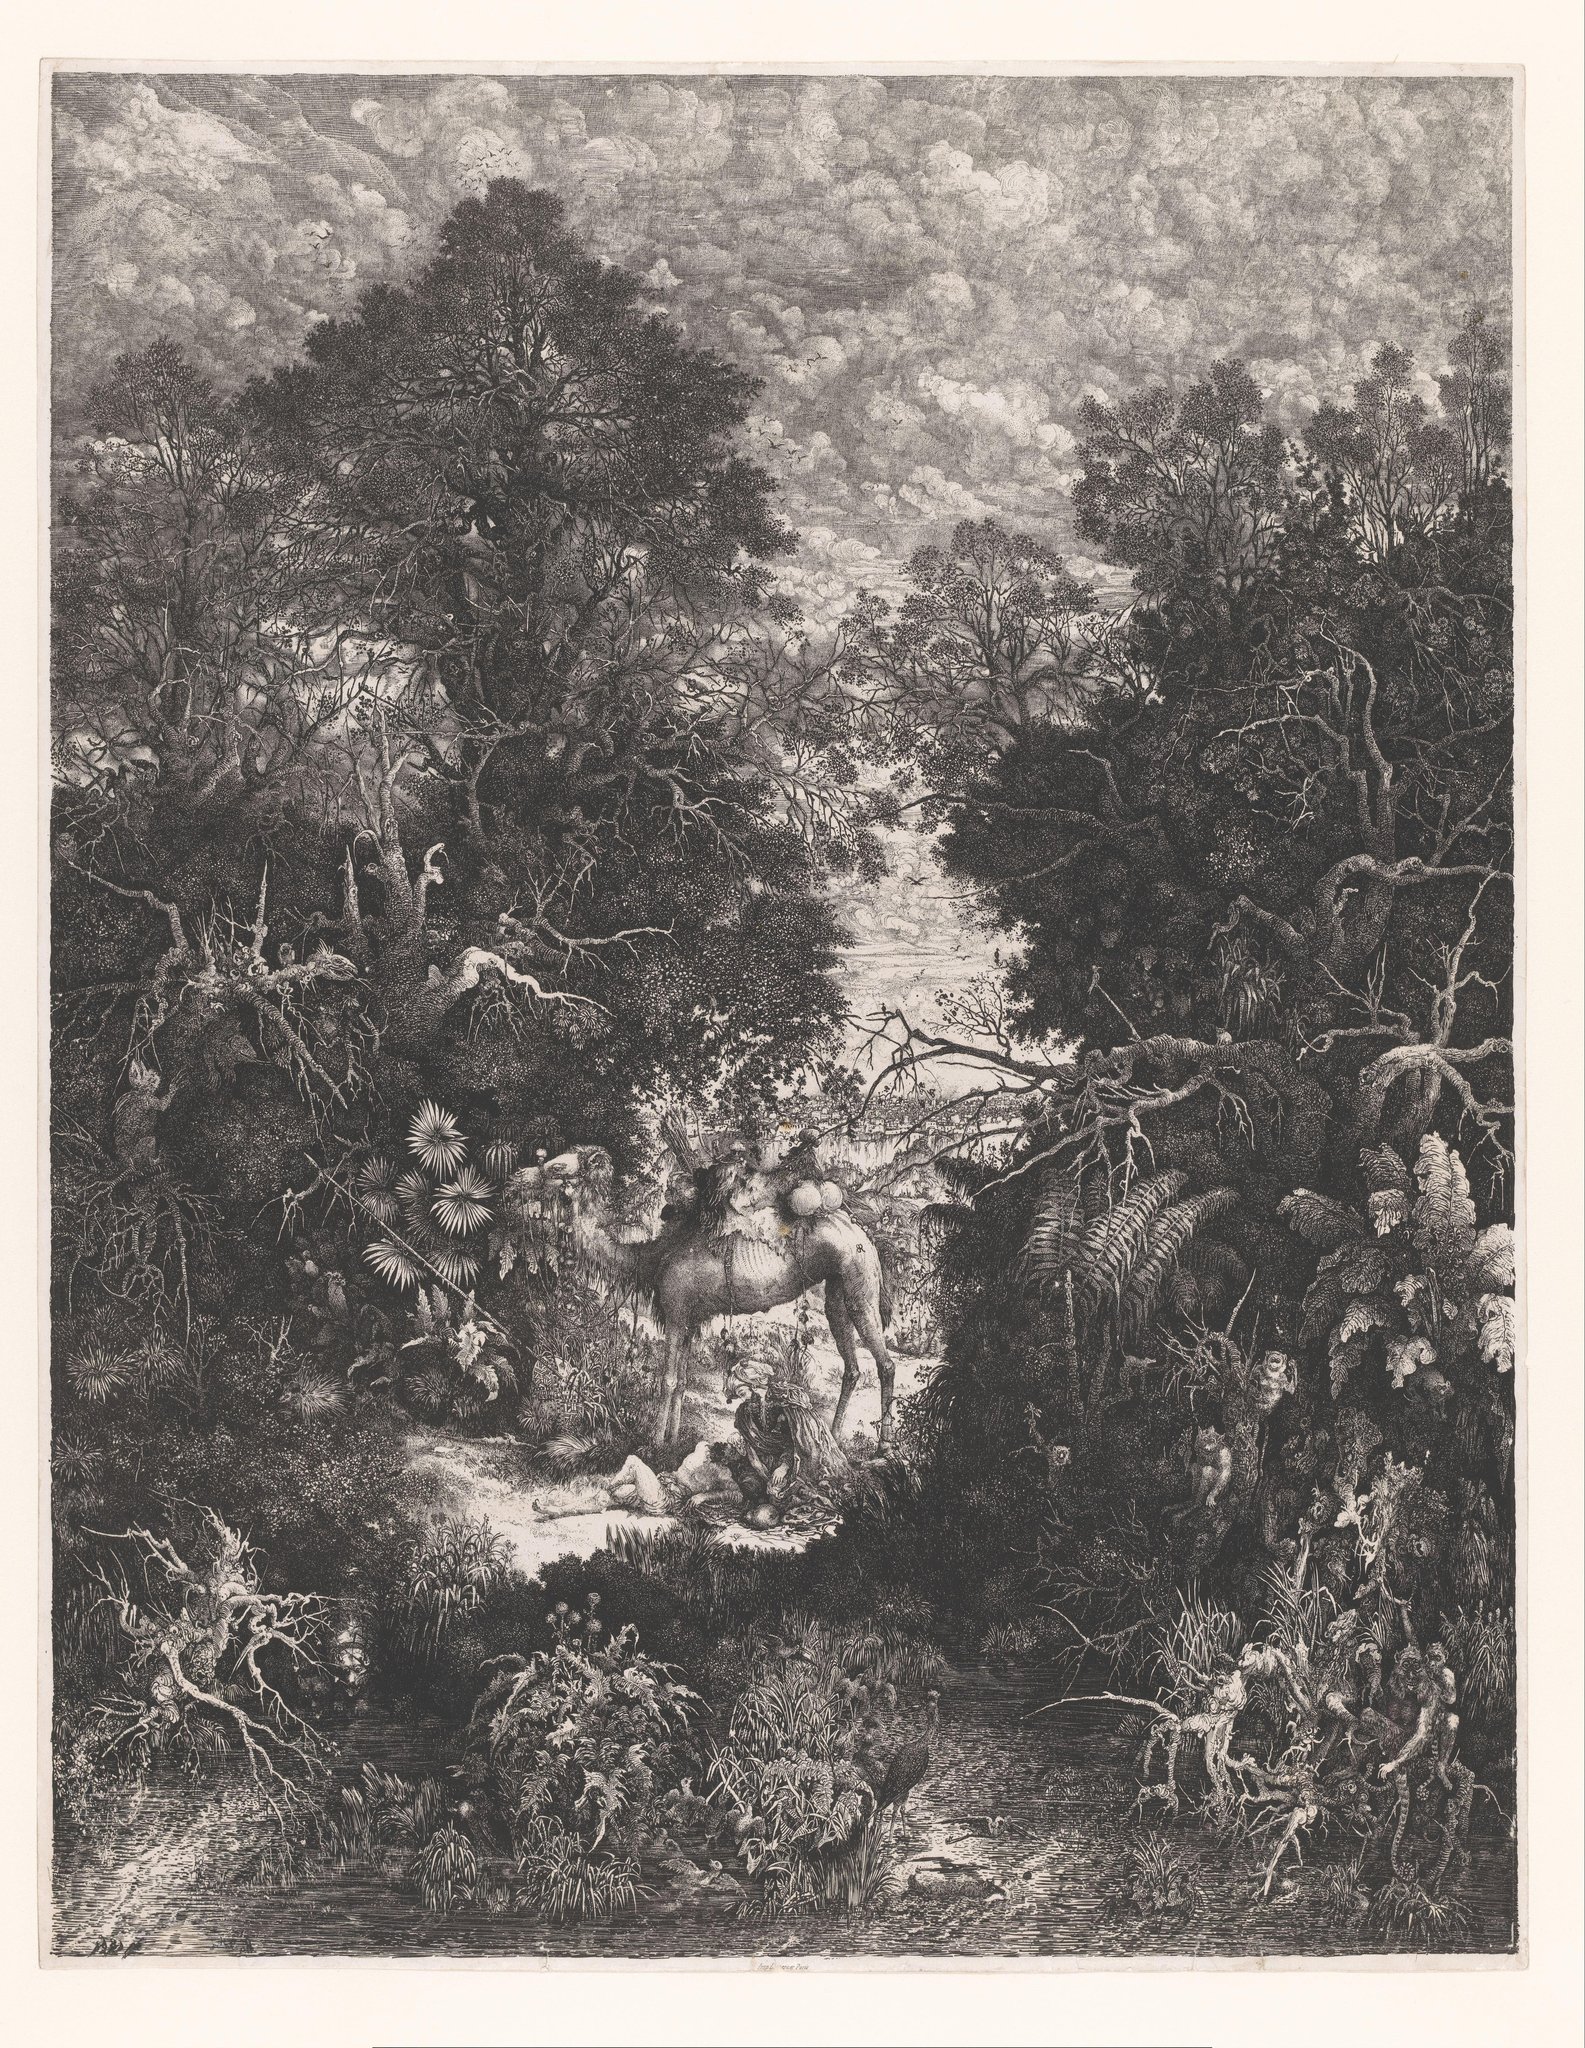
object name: print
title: Barmhartige samaritaan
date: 1861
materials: paper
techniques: pen lithography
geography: paris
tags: jungle (+ landscape (in the non-temperate zone) with figures, staffage), a samaritan tending the wounds of the traveller